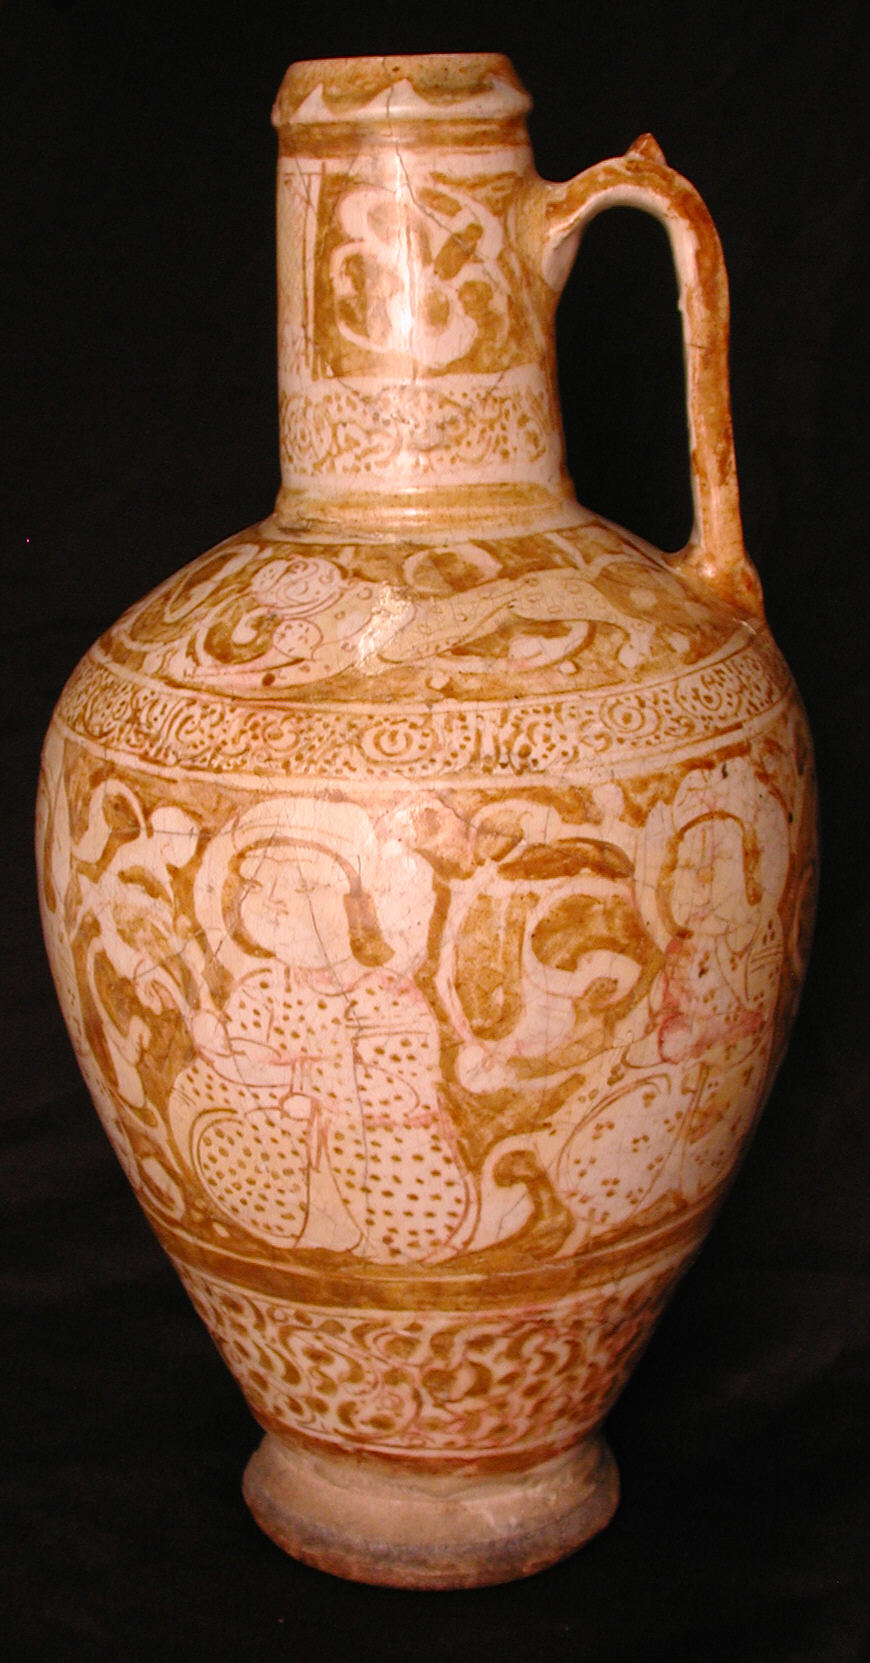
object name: ewer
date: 1101-1300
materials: glaze, stonepaste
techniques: luster painting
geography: iran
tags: human figures